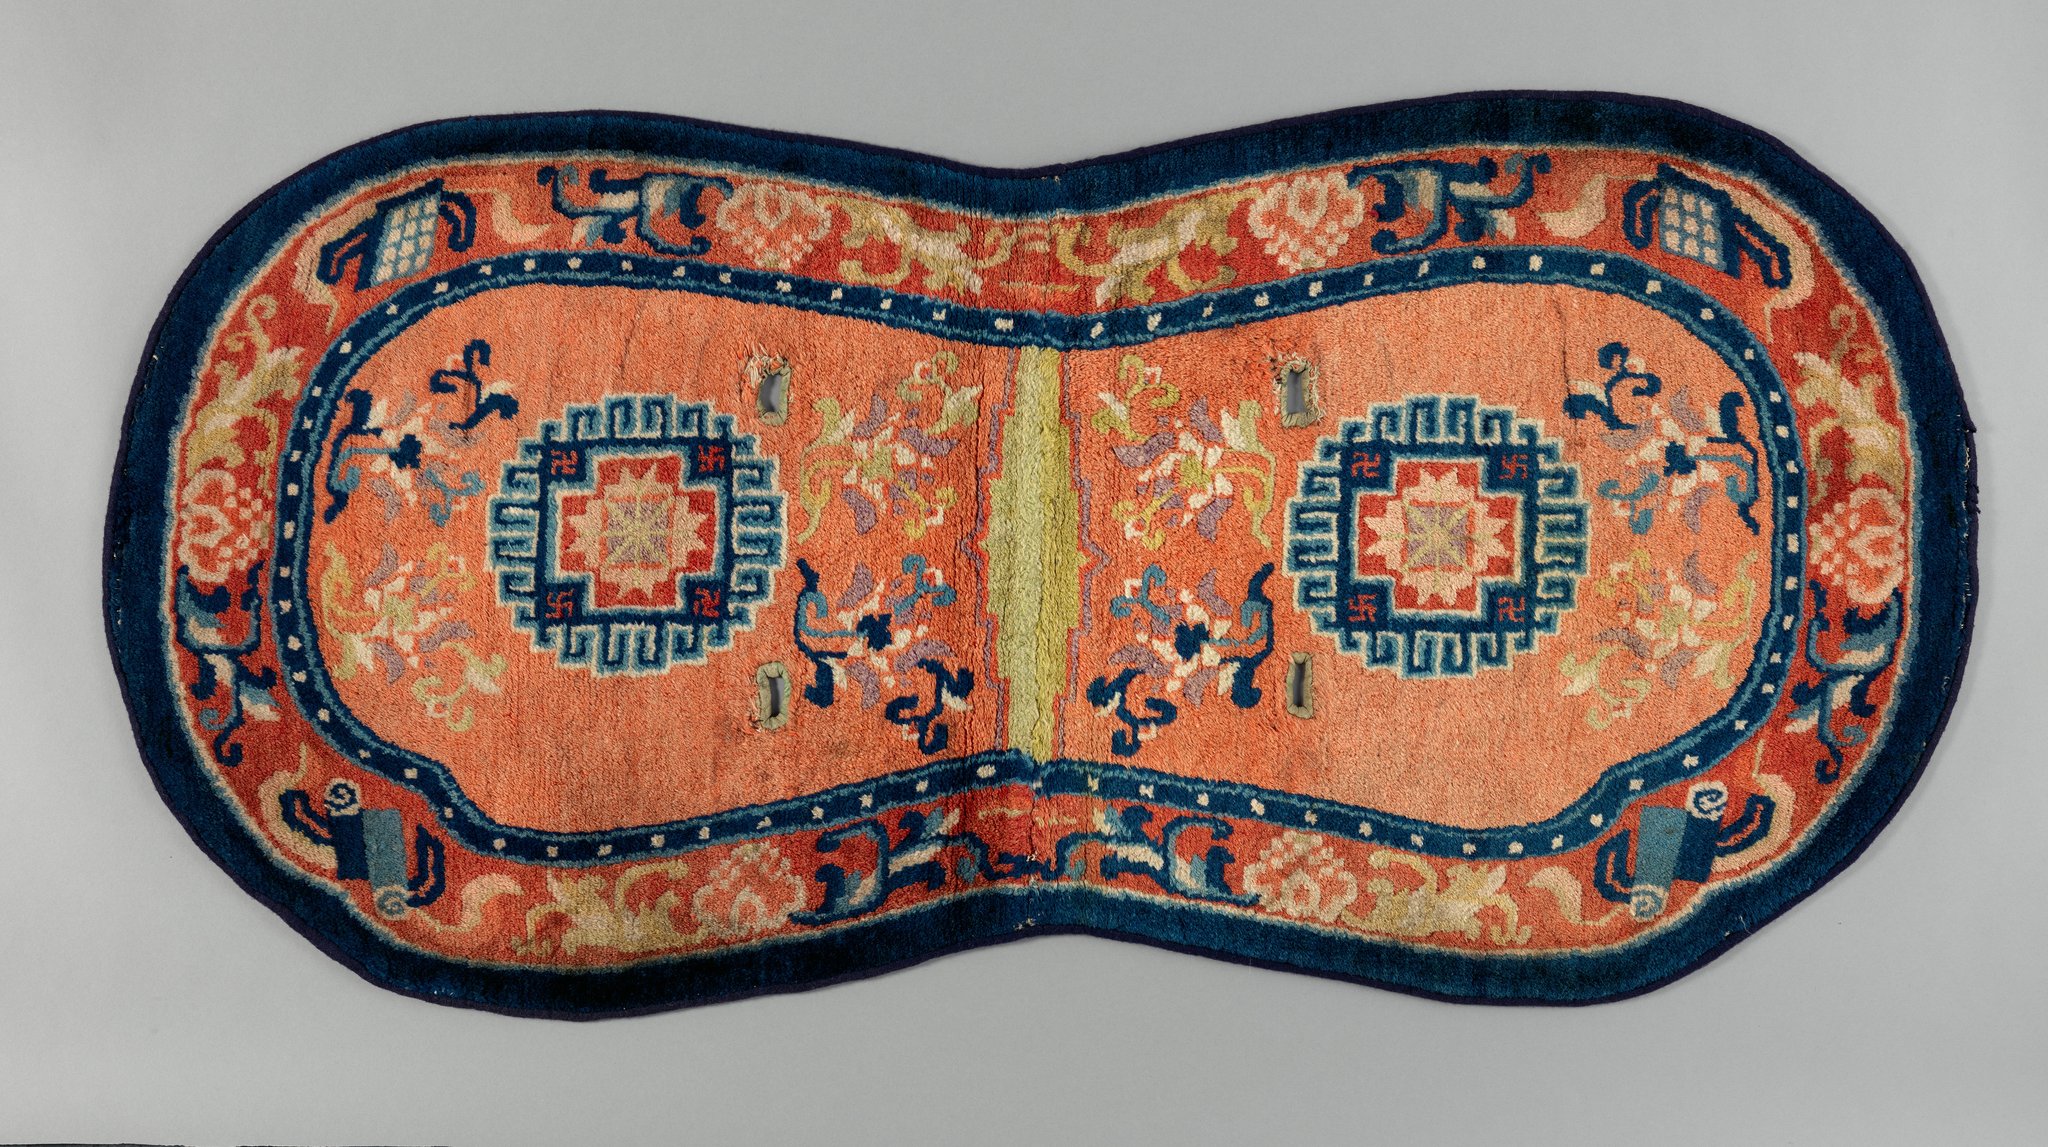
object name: saddle rug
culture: inner mongolian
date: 1867-1900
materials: cotton, wool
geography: china